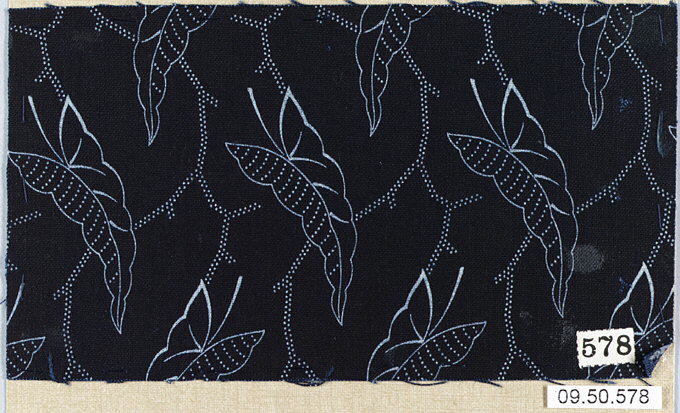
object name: piece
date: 1801-1900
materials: cotton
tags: leaves